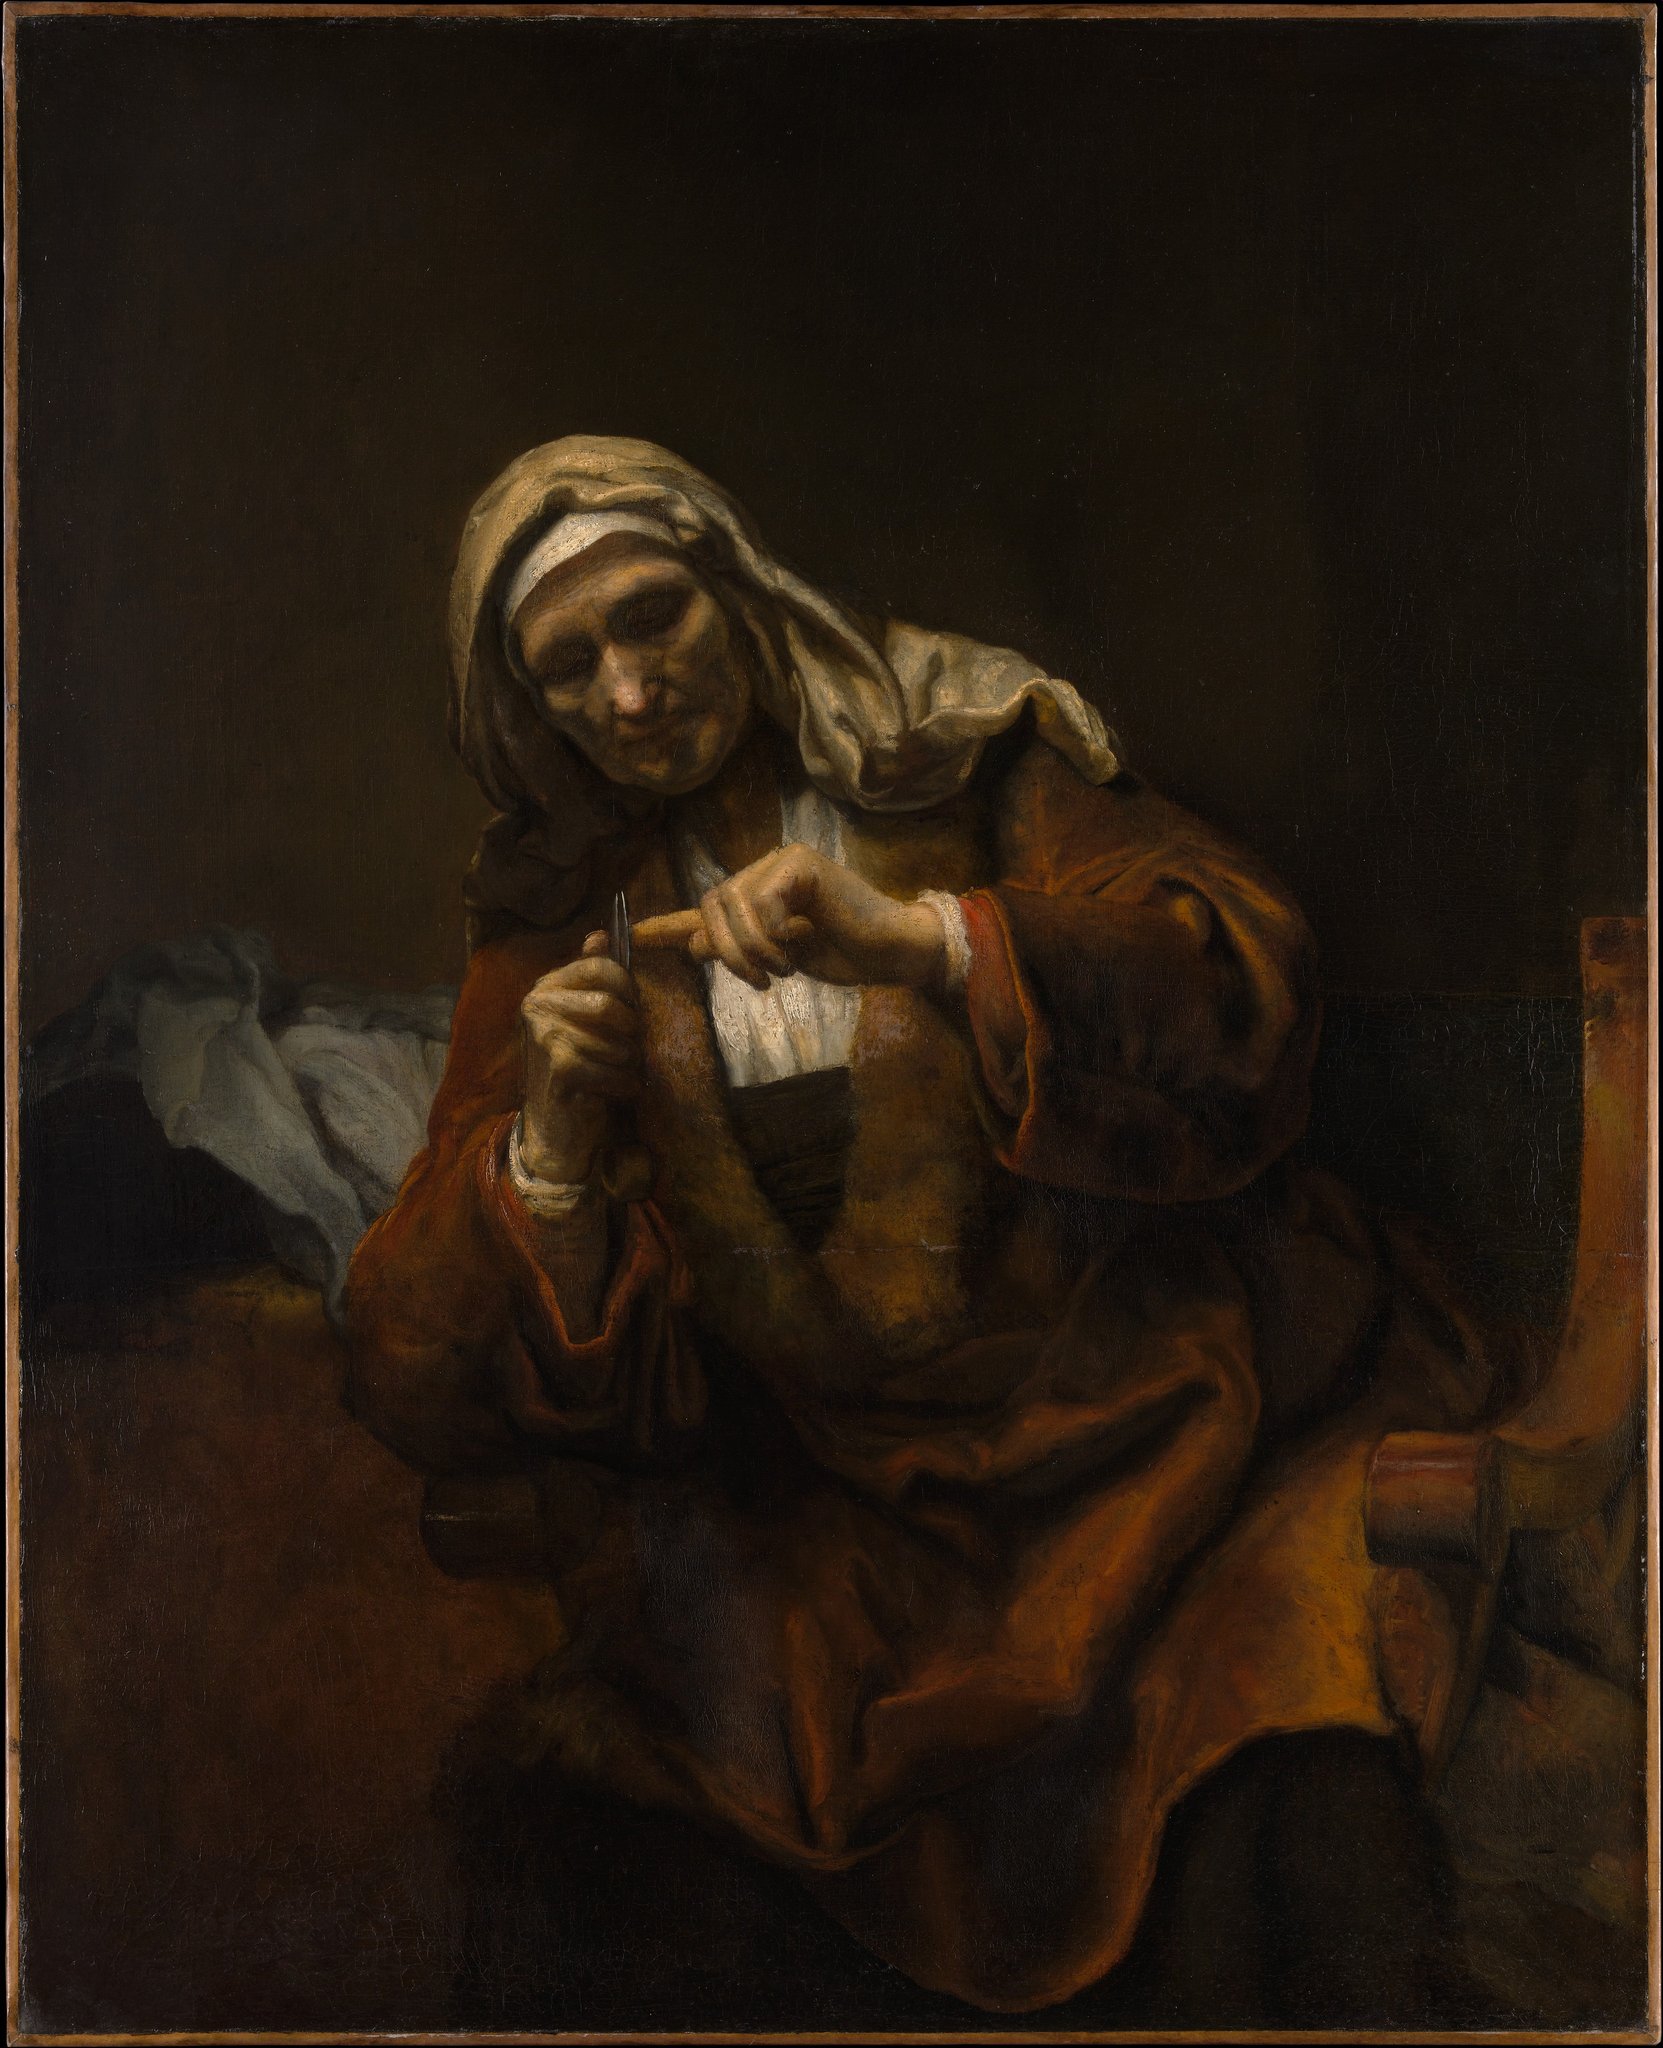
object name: painting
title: Old Woman Cutting Her Nails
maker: rembrandt van rijn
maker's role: artist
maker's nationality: dutch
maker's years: 1606-1669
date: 1655-1660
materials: canvas, oil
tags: portraits,women